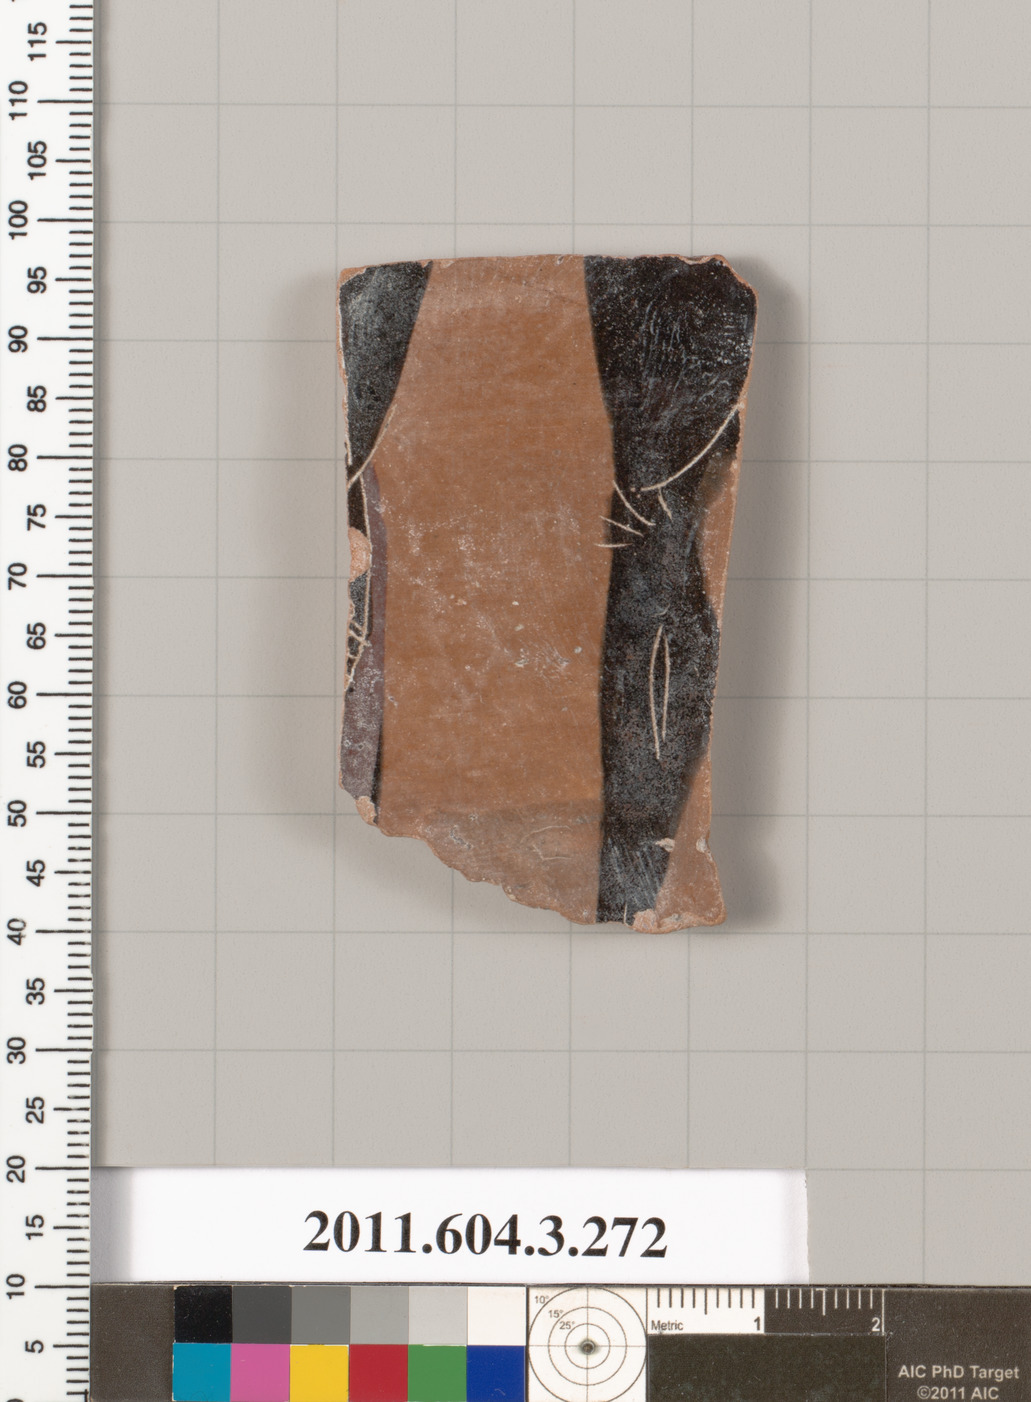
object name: neck amphora fragment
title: Terracotta fragment of a neck-amphora (jar)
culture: greek, attic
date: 534-468 BCE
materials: terracotta